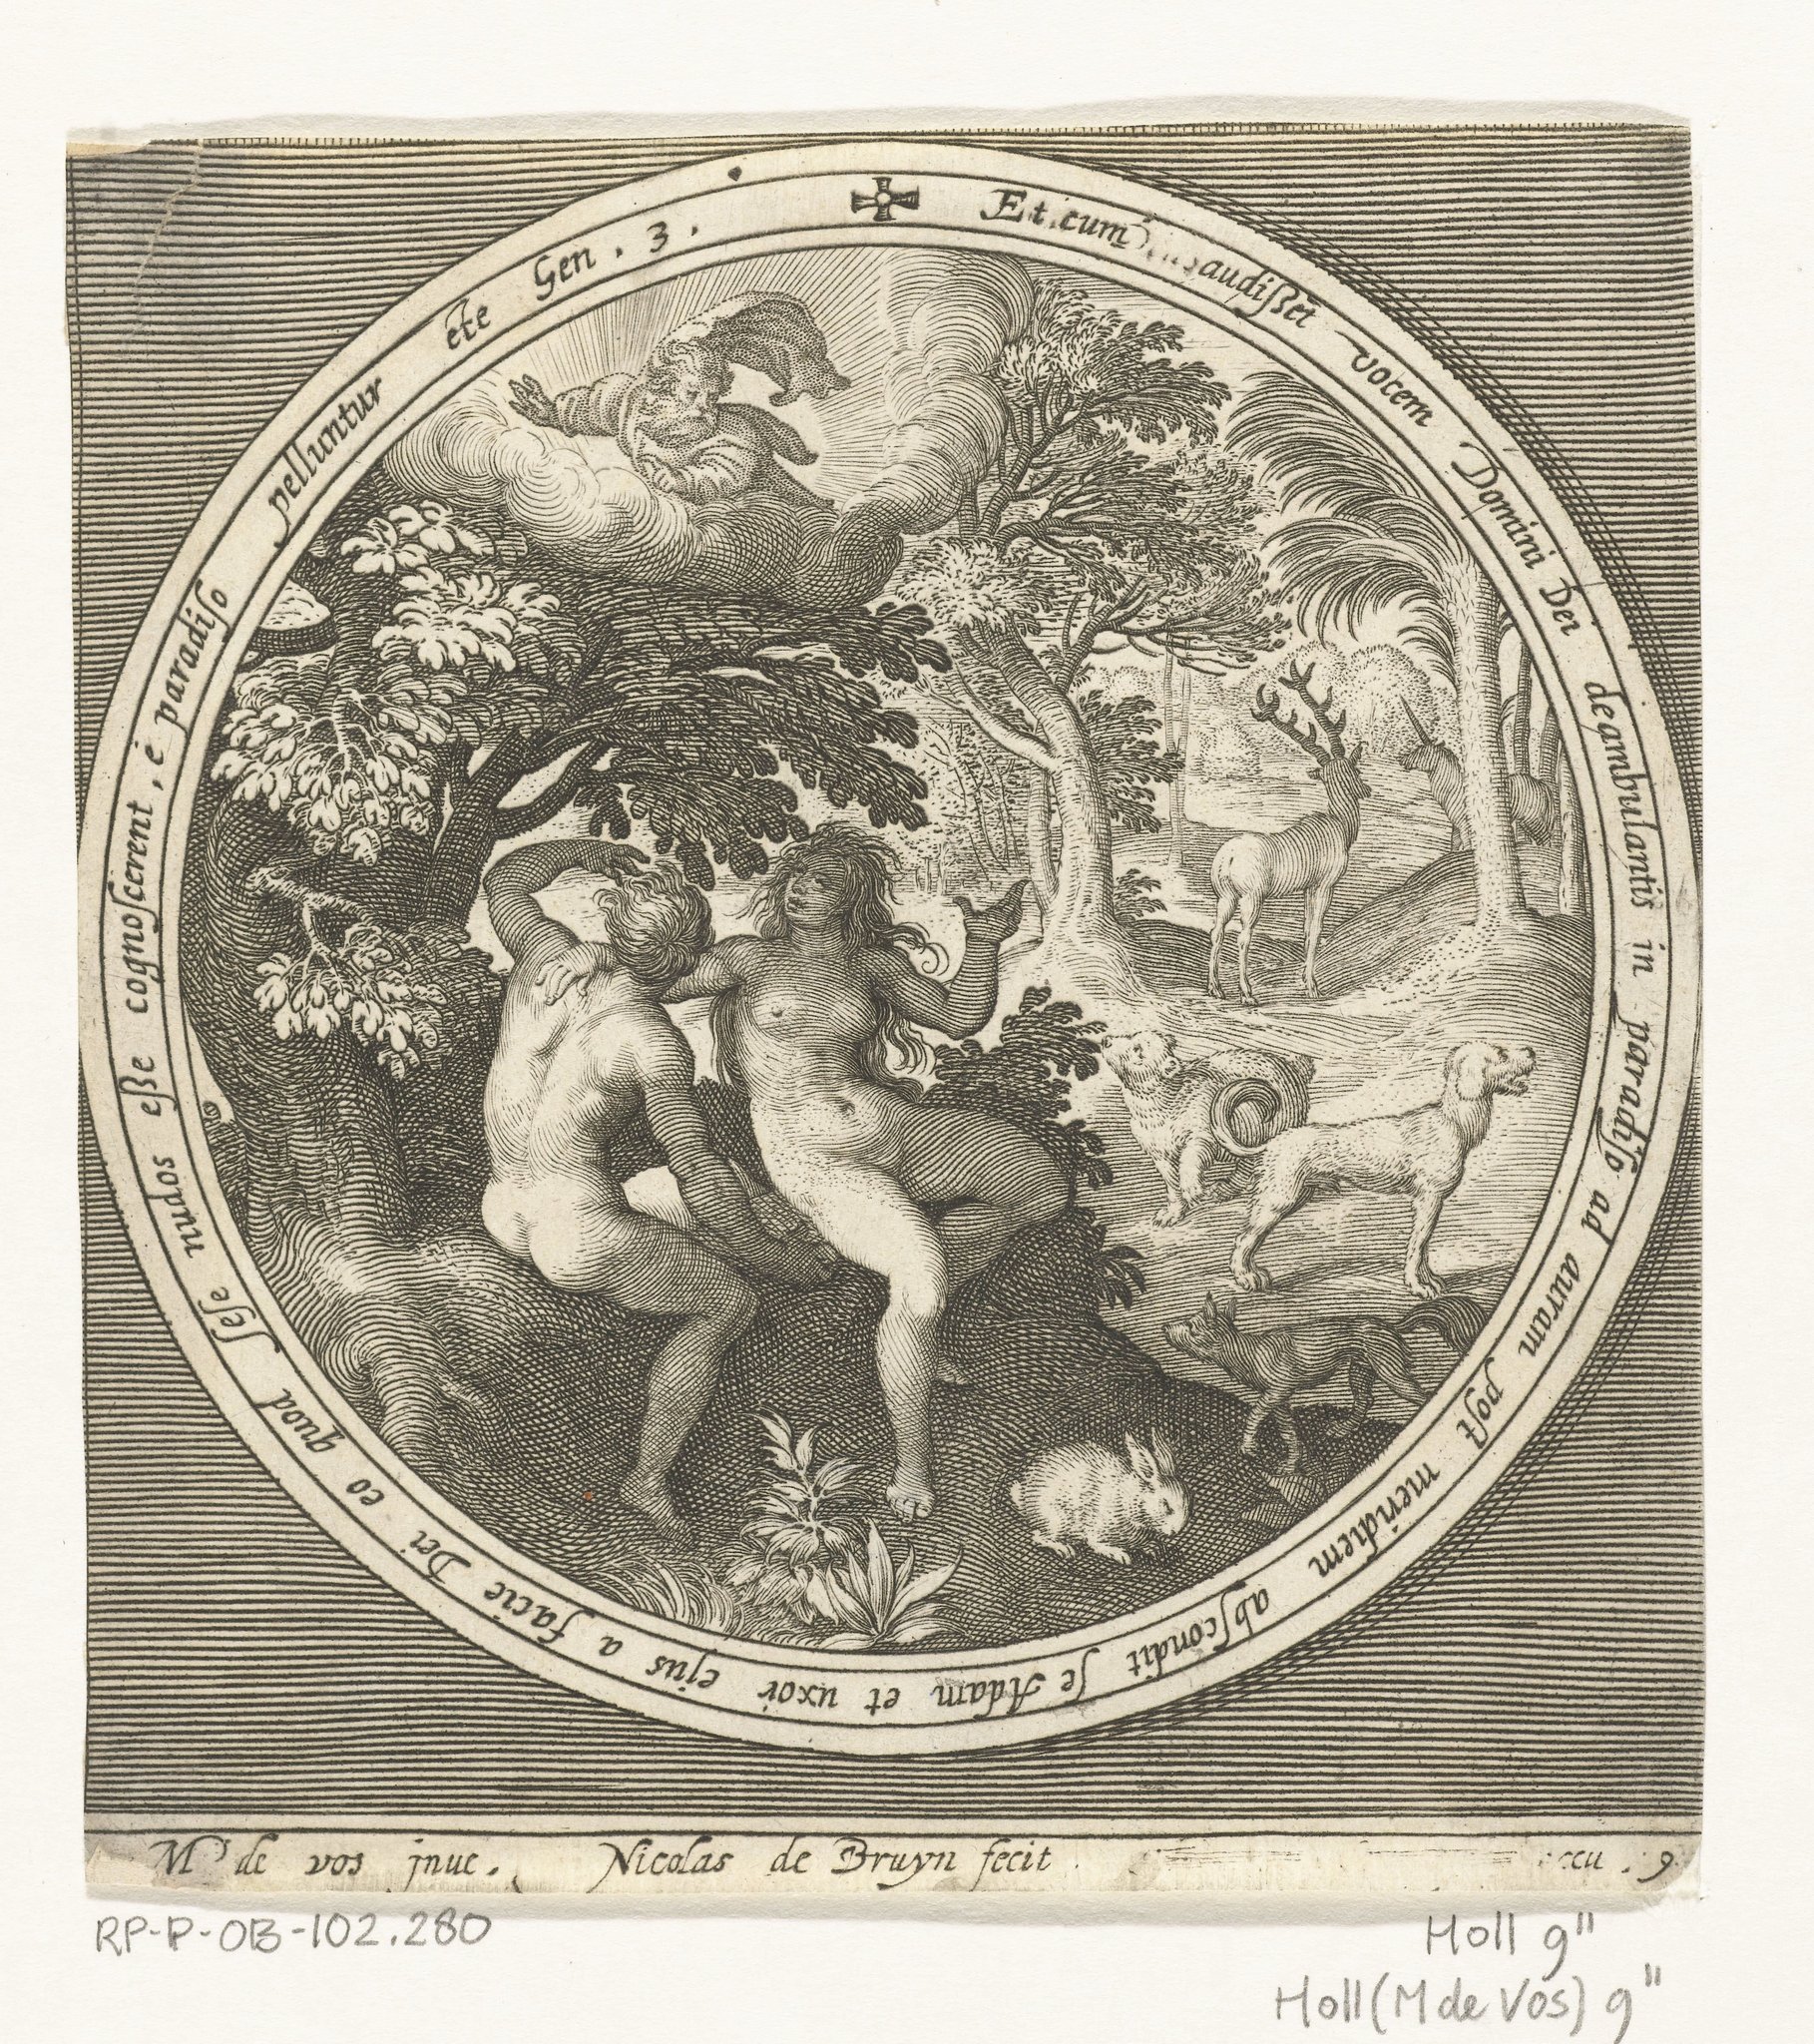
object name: print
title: Adam en Eva verbergen zich voor God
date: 1581-1656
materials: paper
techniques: engraving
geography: netherlands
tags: adam and eve discover their nakedness; they cover themselves with their hands or with leaves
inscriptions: collector's mark: Lugt 2228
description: Adam en Eva verbergen zich door schaamte over hun naaktheid voor God. In medaillon met als opschrift een bijbeltekst in Latijn uit Genesis 3 binnen rechthoekige omlijsting.